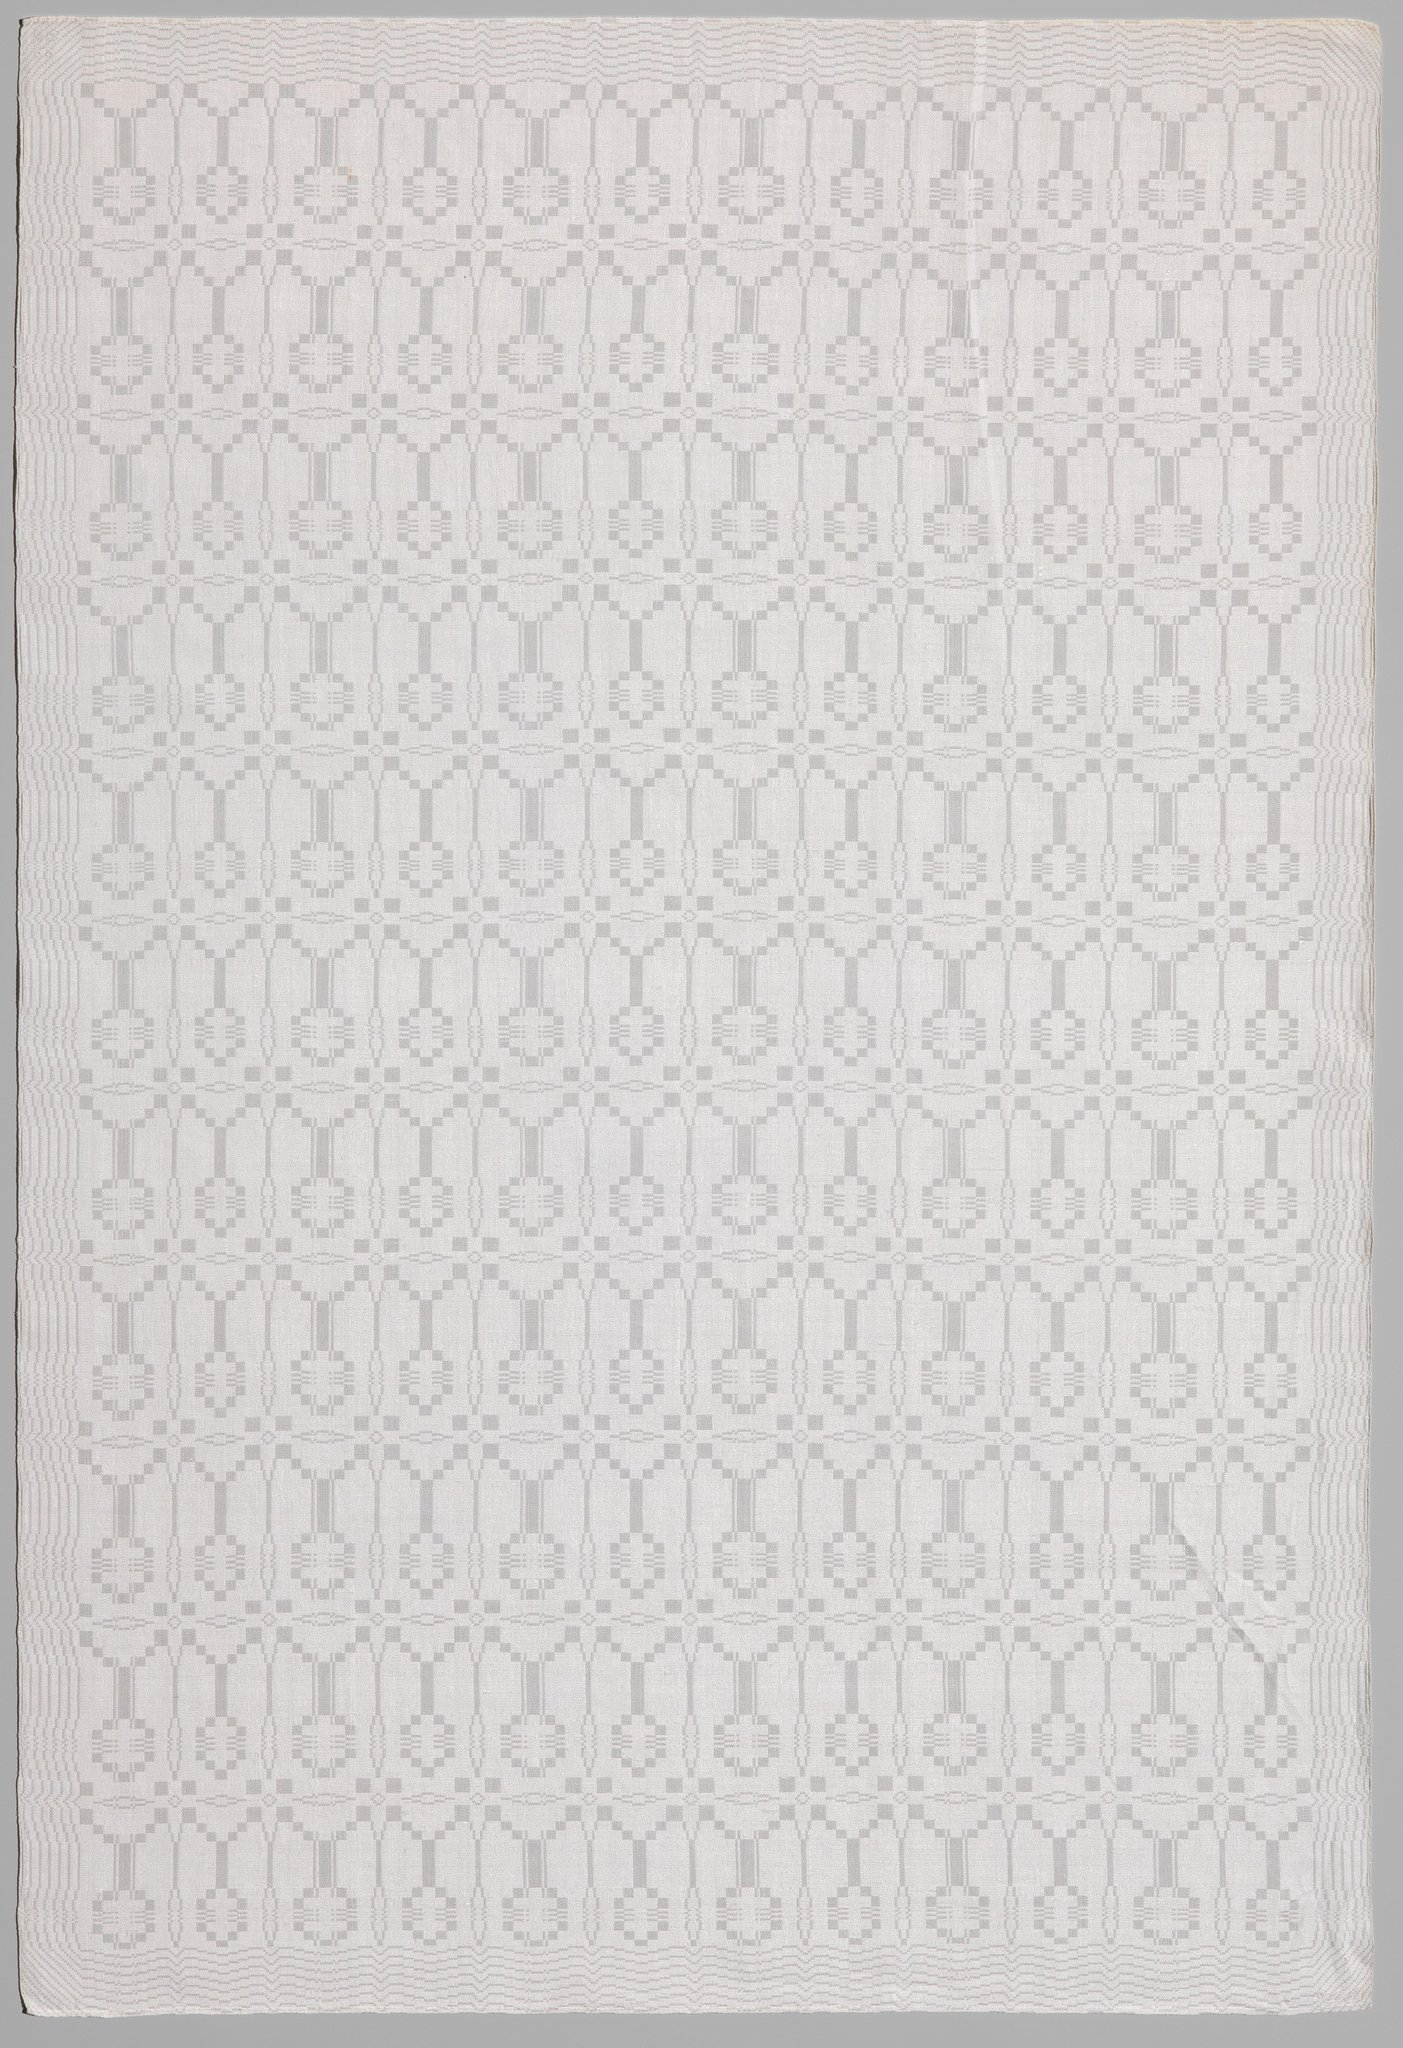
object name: napkin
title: Servet van linnen met pellenpatroon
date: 1726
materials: linen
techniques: peeled fabric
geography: northern netherlands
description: wit linnen servet met pellen patroon, merk GS 60 en 1726